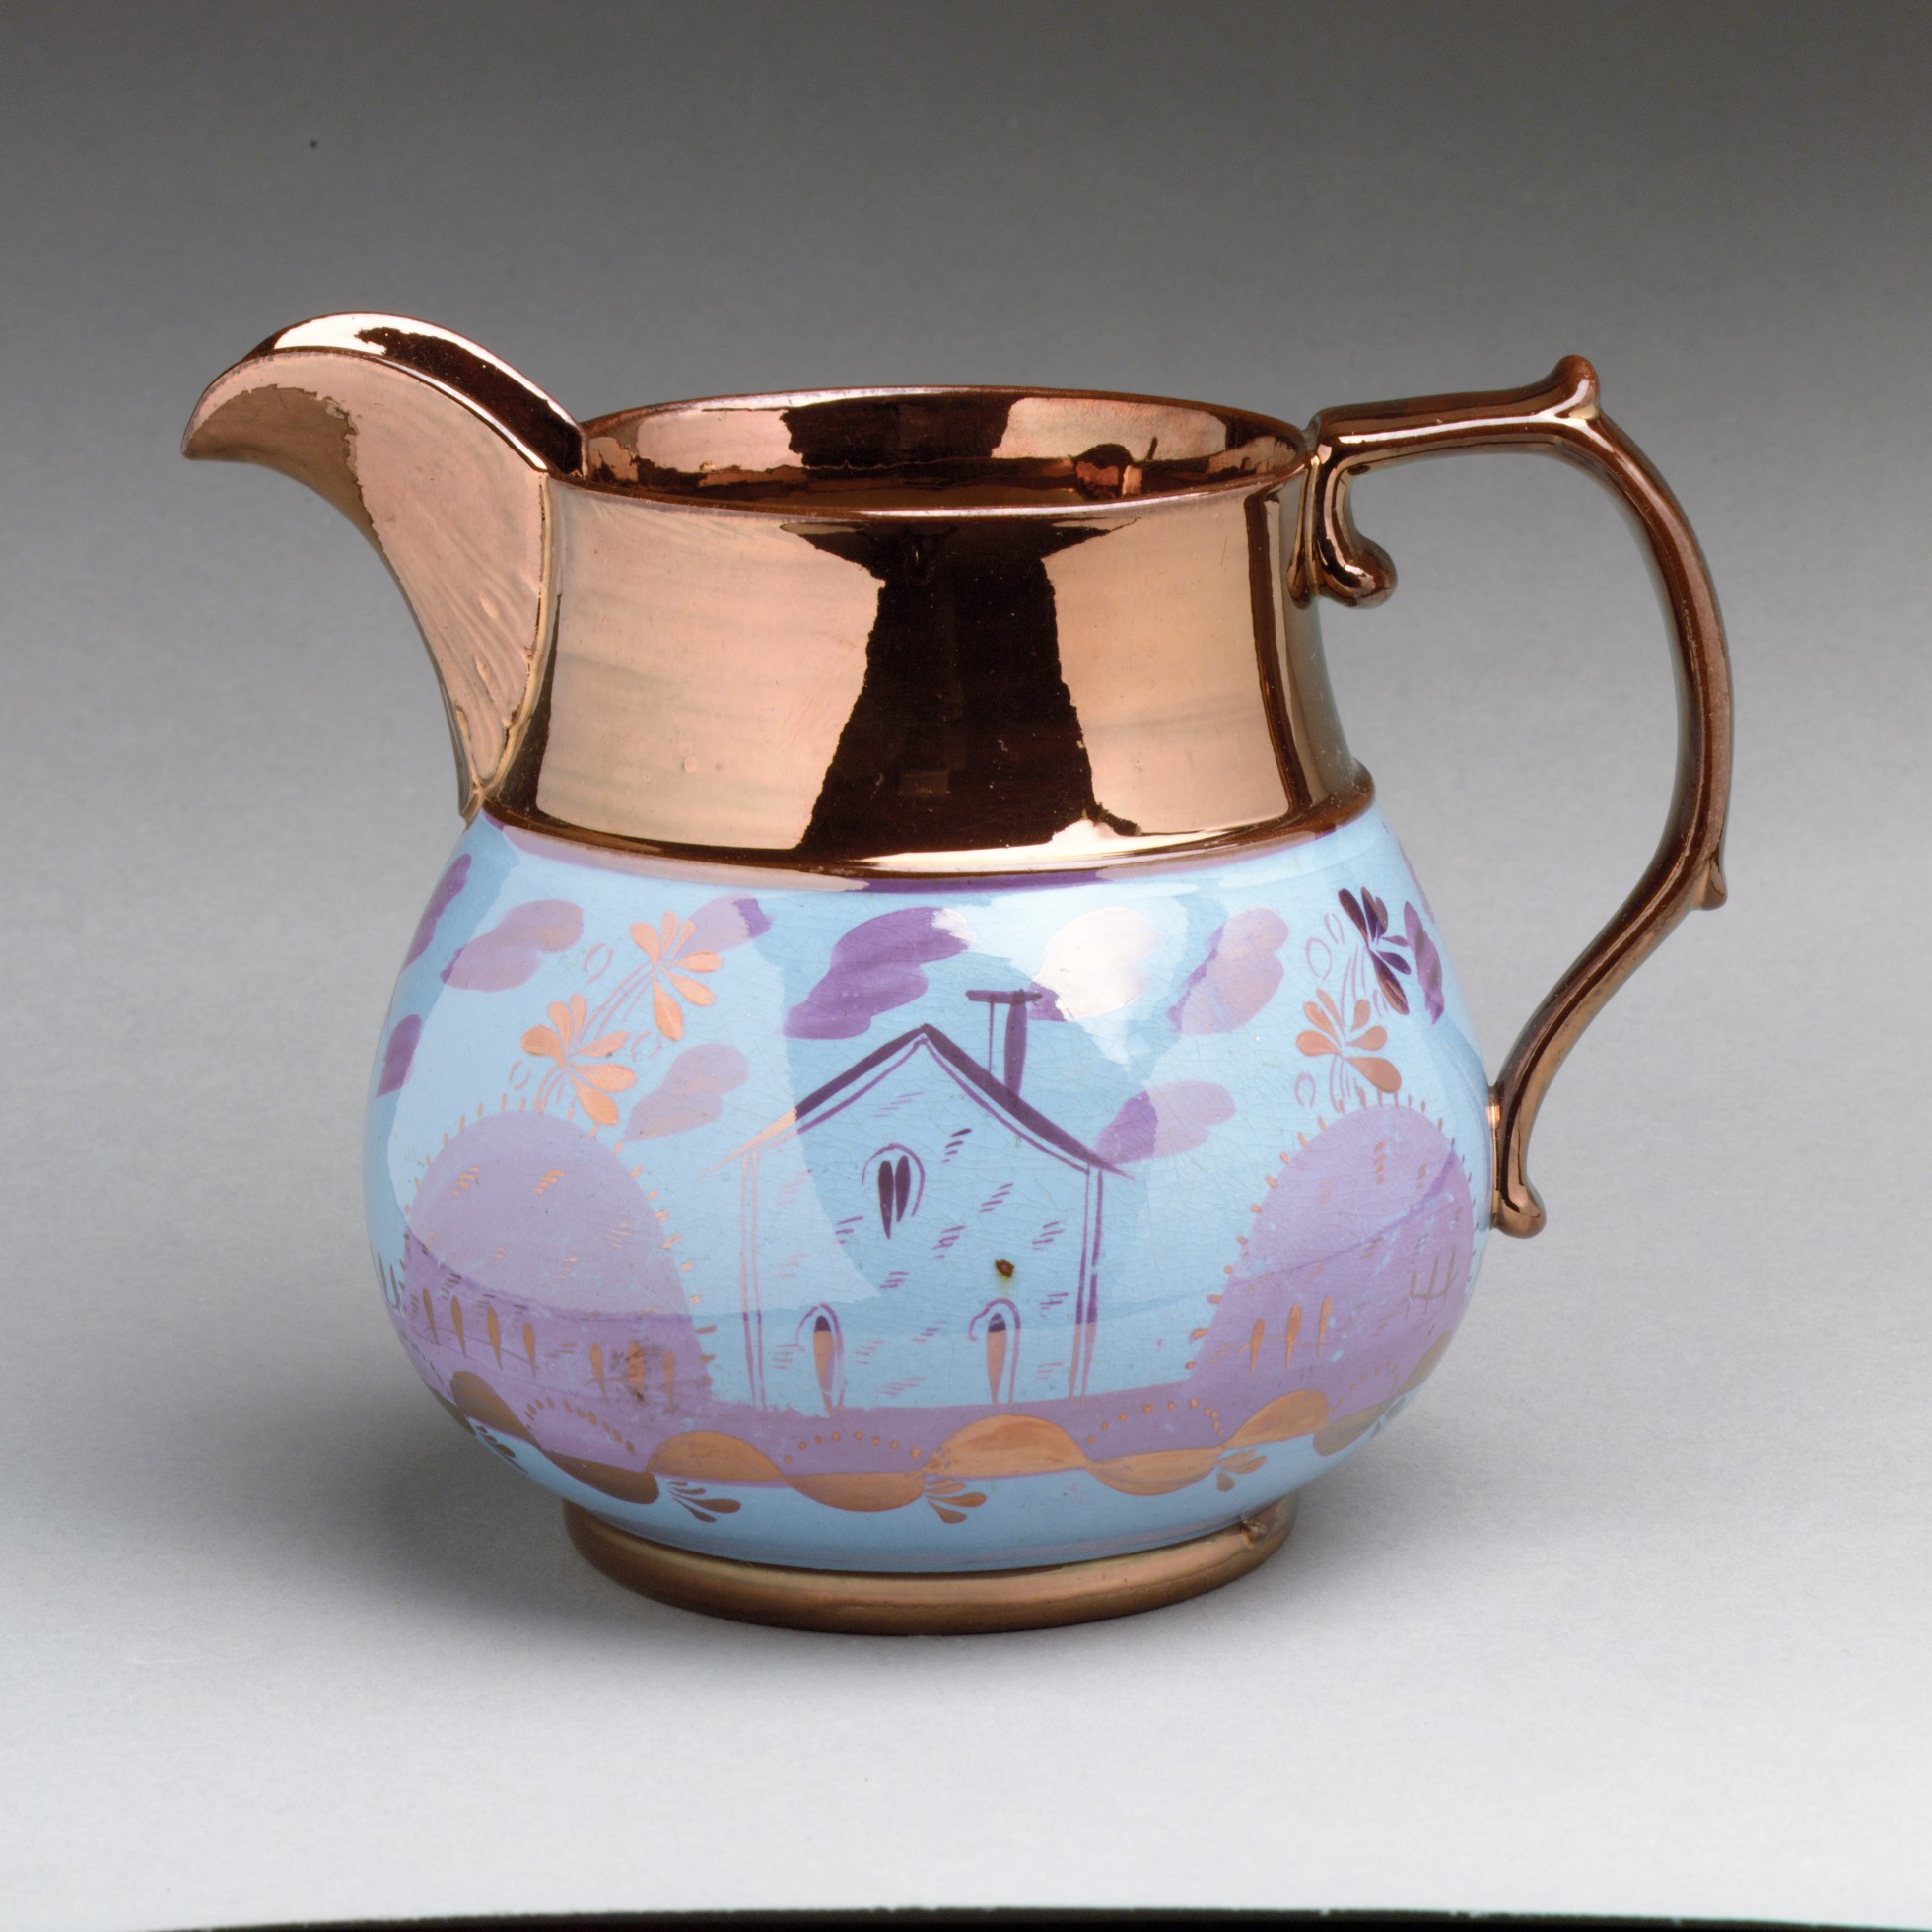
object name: pitcher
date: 1801-1900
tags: houses